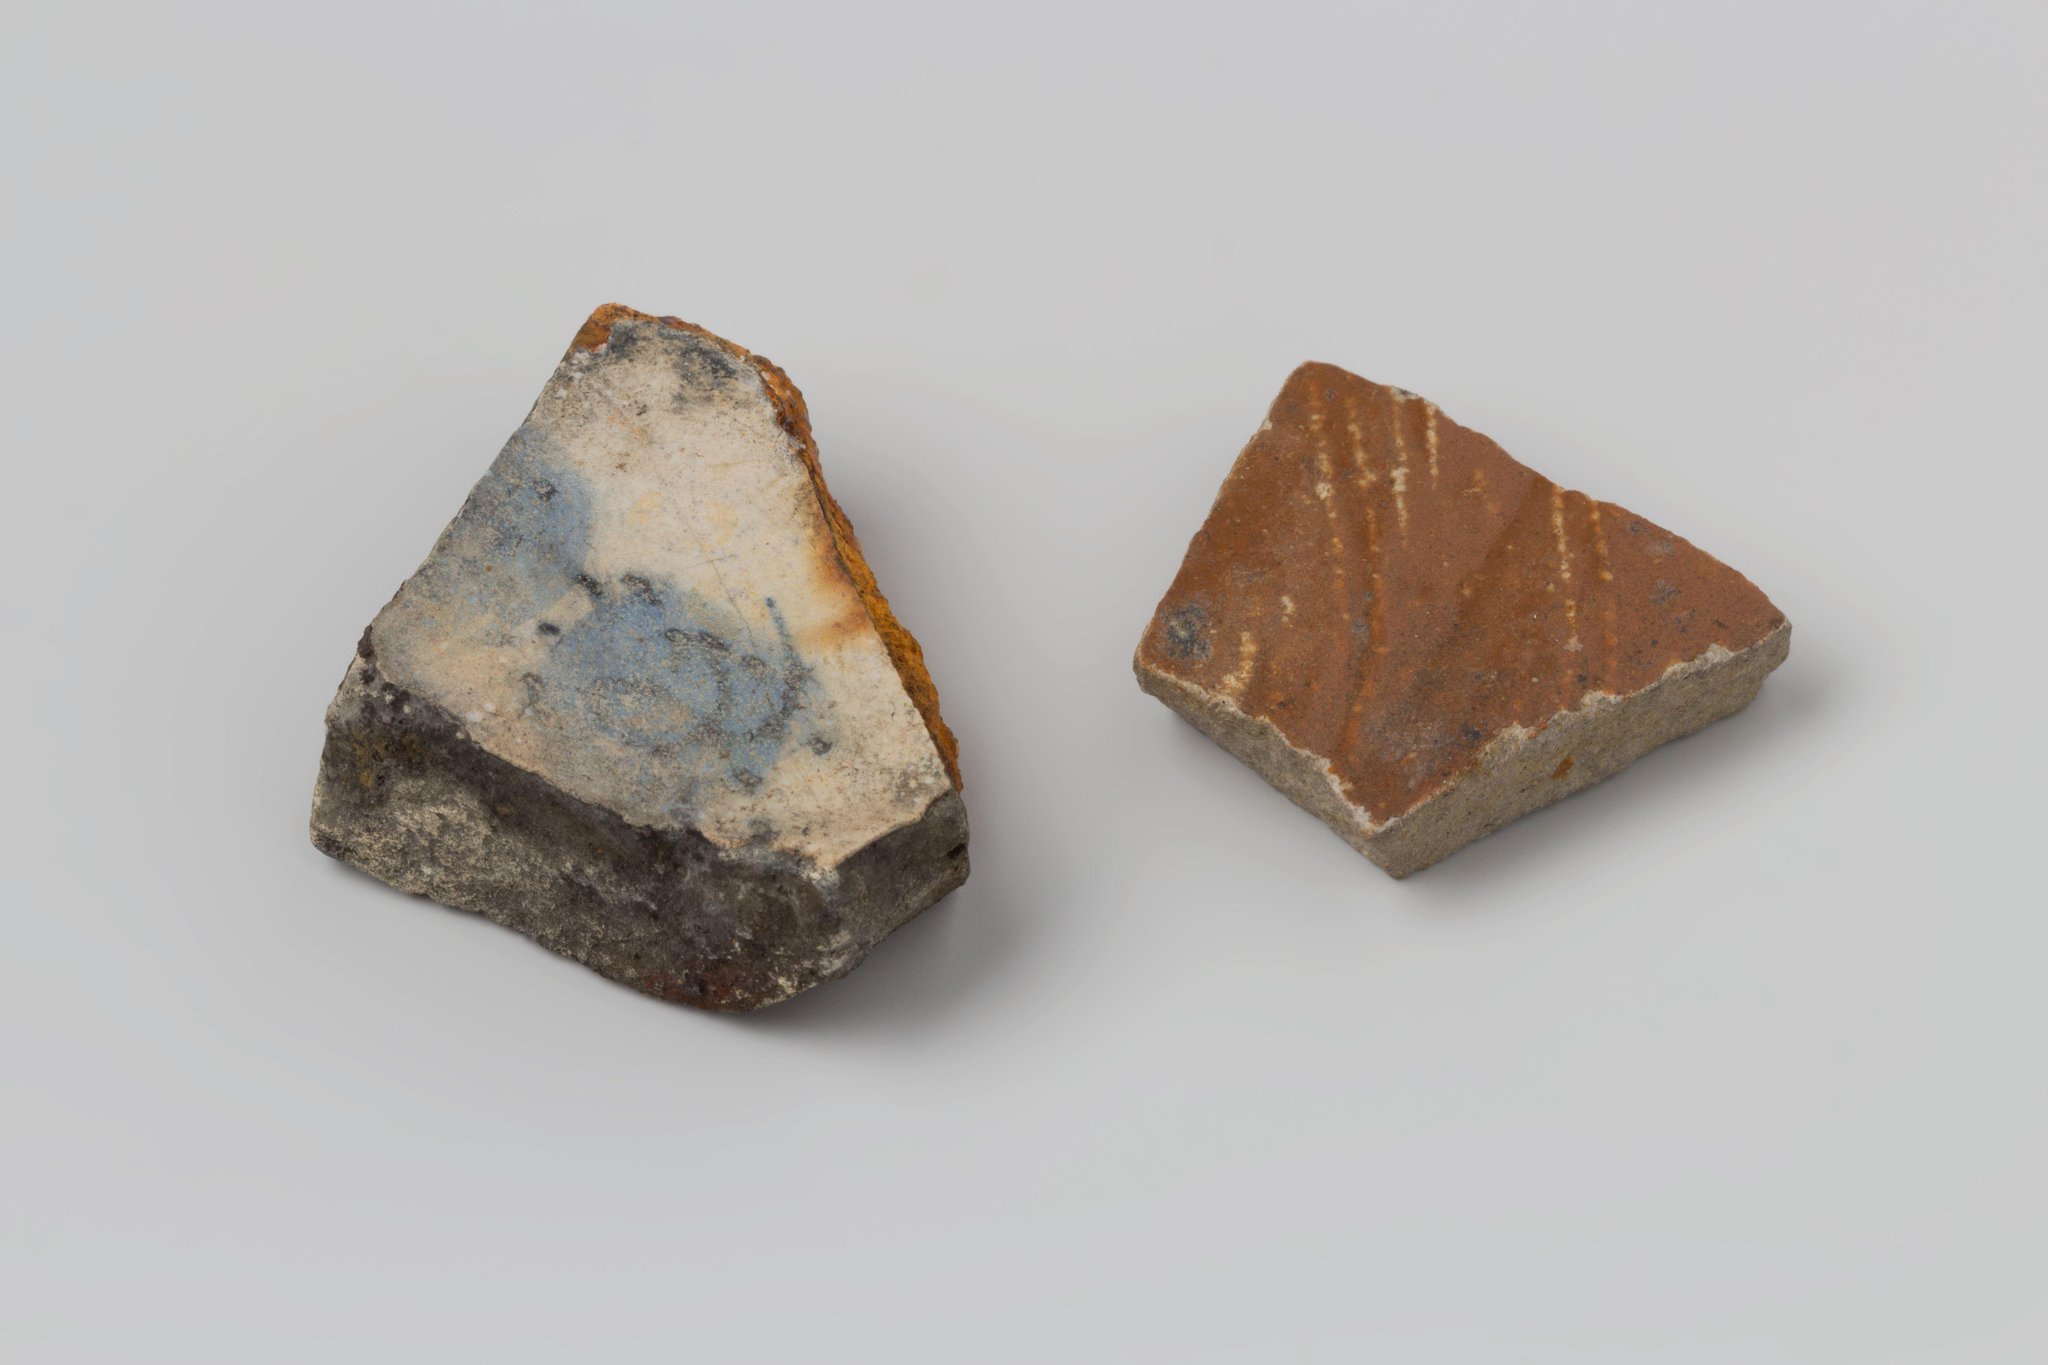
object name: tile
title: Scherf van een kan en een tegel uit het wrak van de Oost-Indiëvaarder 't Vliegend Hart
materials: earthenware, glaze, stoneware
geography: netherlands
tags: 't vliegend hart (schip), verenigde oostindische compagnie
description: Scherf van een krakelée delftsblauwe tegel met roestaanslag en een scherf van een steengoed kan, welke van buiten roodbruin en van binnen lichtblauw is geglazuurd.